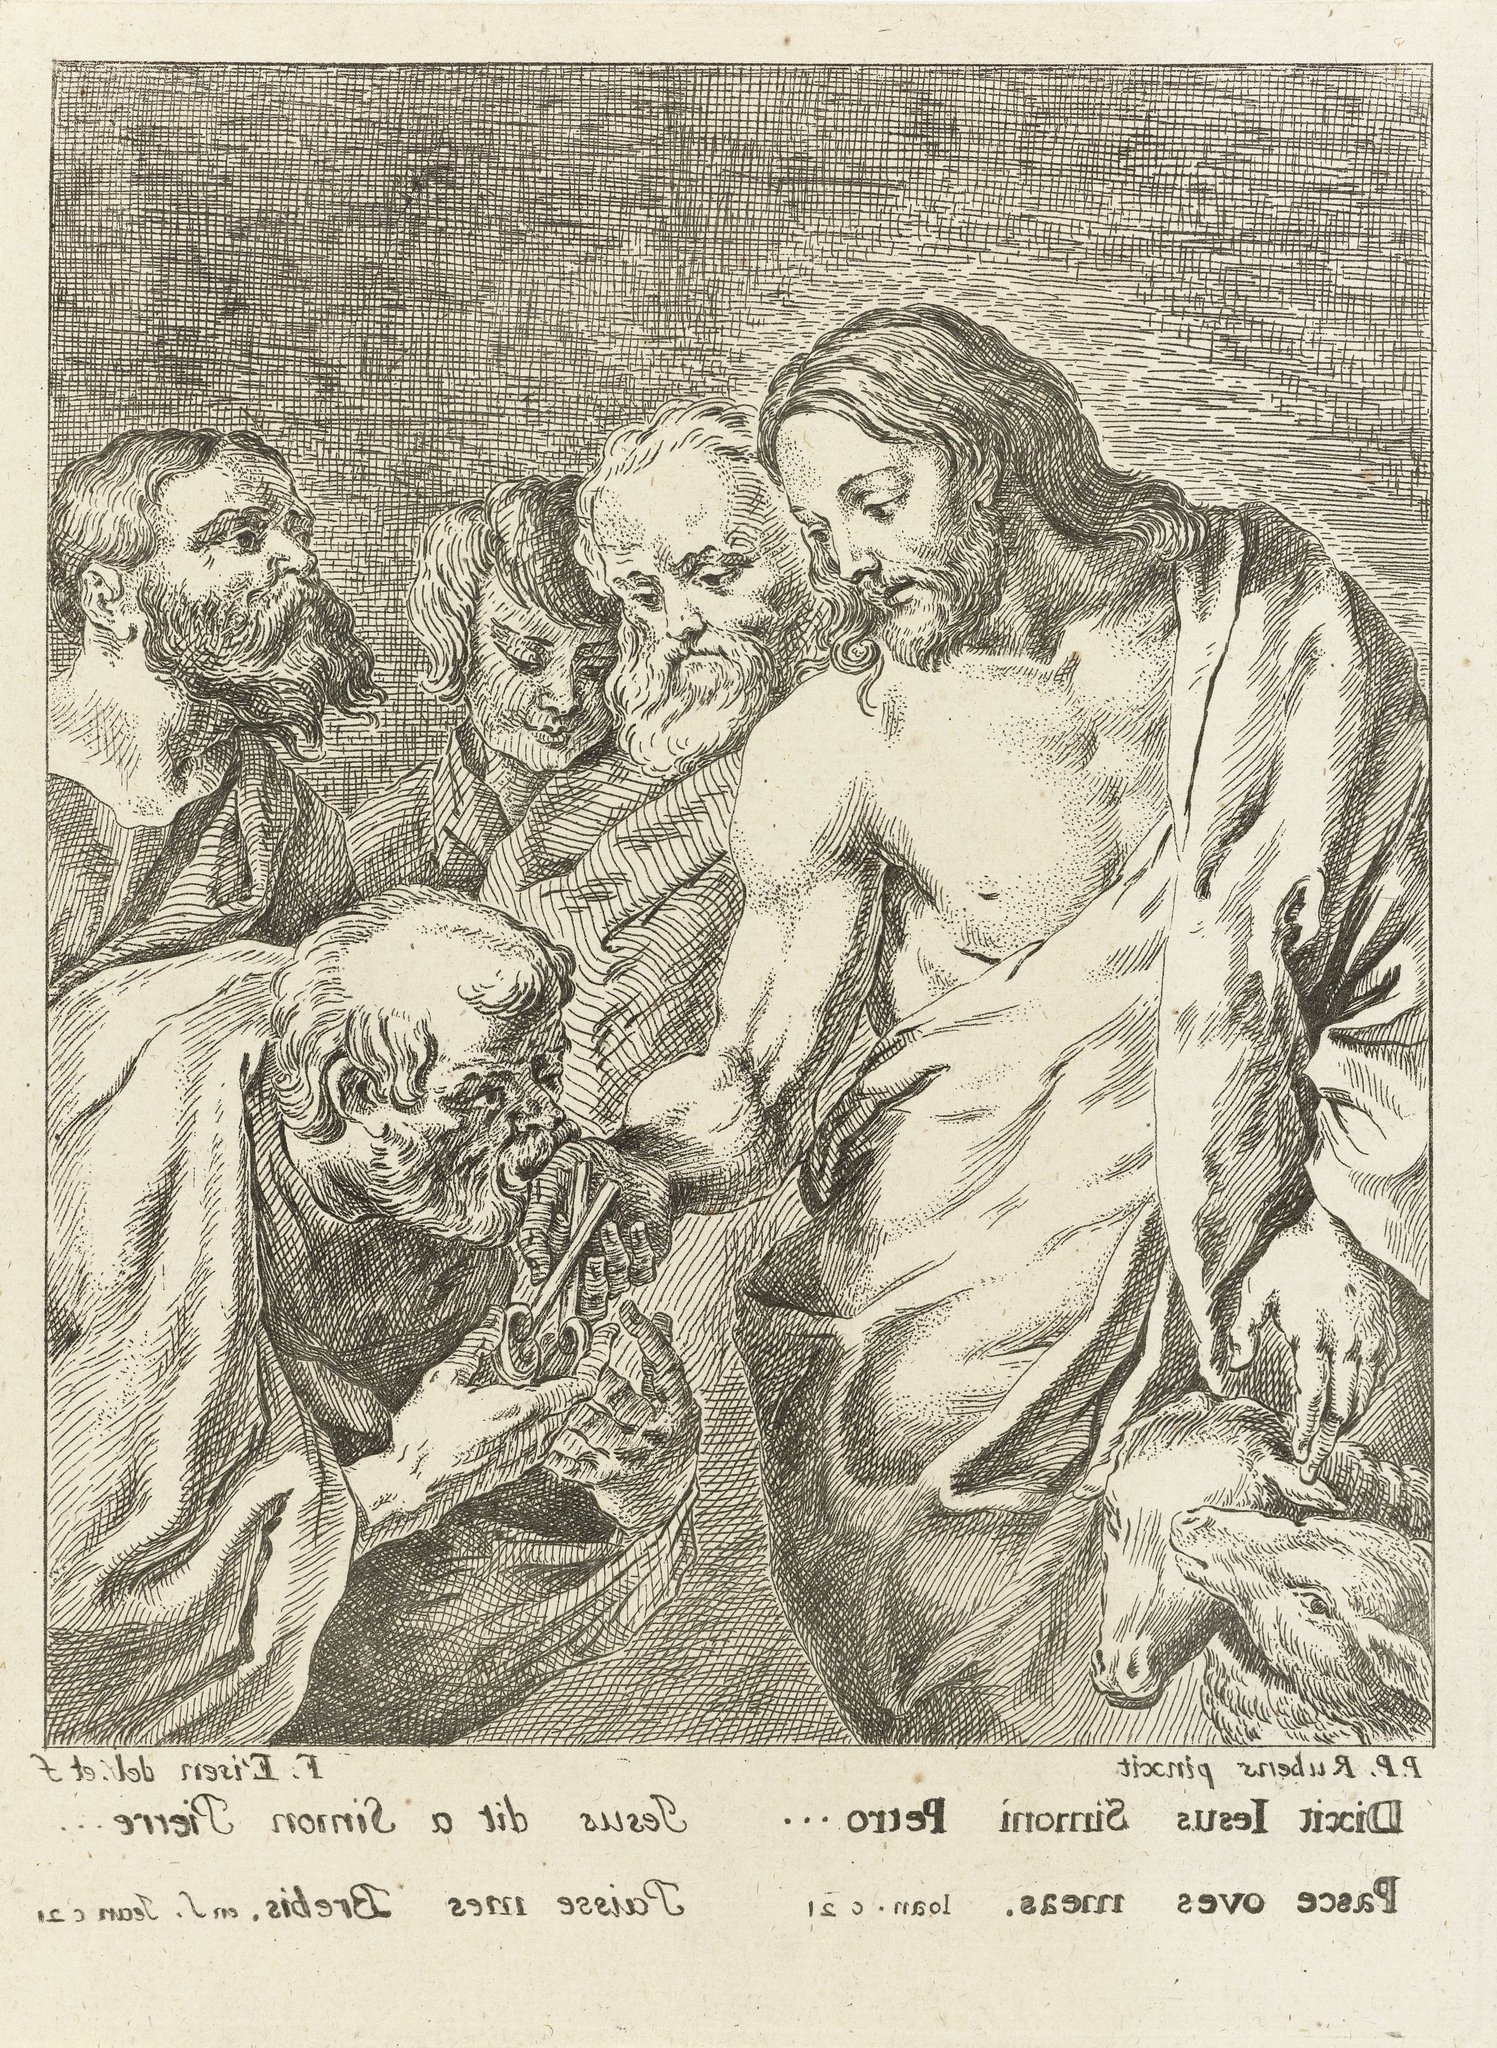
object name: print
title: Christus geeft de sleutels aan Petrus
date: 1705-1778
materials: paper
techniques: printmaking, etching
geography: paris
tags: christ gives the keys of heaven to peter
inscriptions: collector's mark: Lugt 1838, collector's mark: Lugt 240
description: Christus geeft de sleutels aan Petrus. Op de achtergrond drie andere discipelen. Onder de voorstelling twee regels Latijn in spiegelbeeld. Tegendruk van de prent met dezelfde titel.